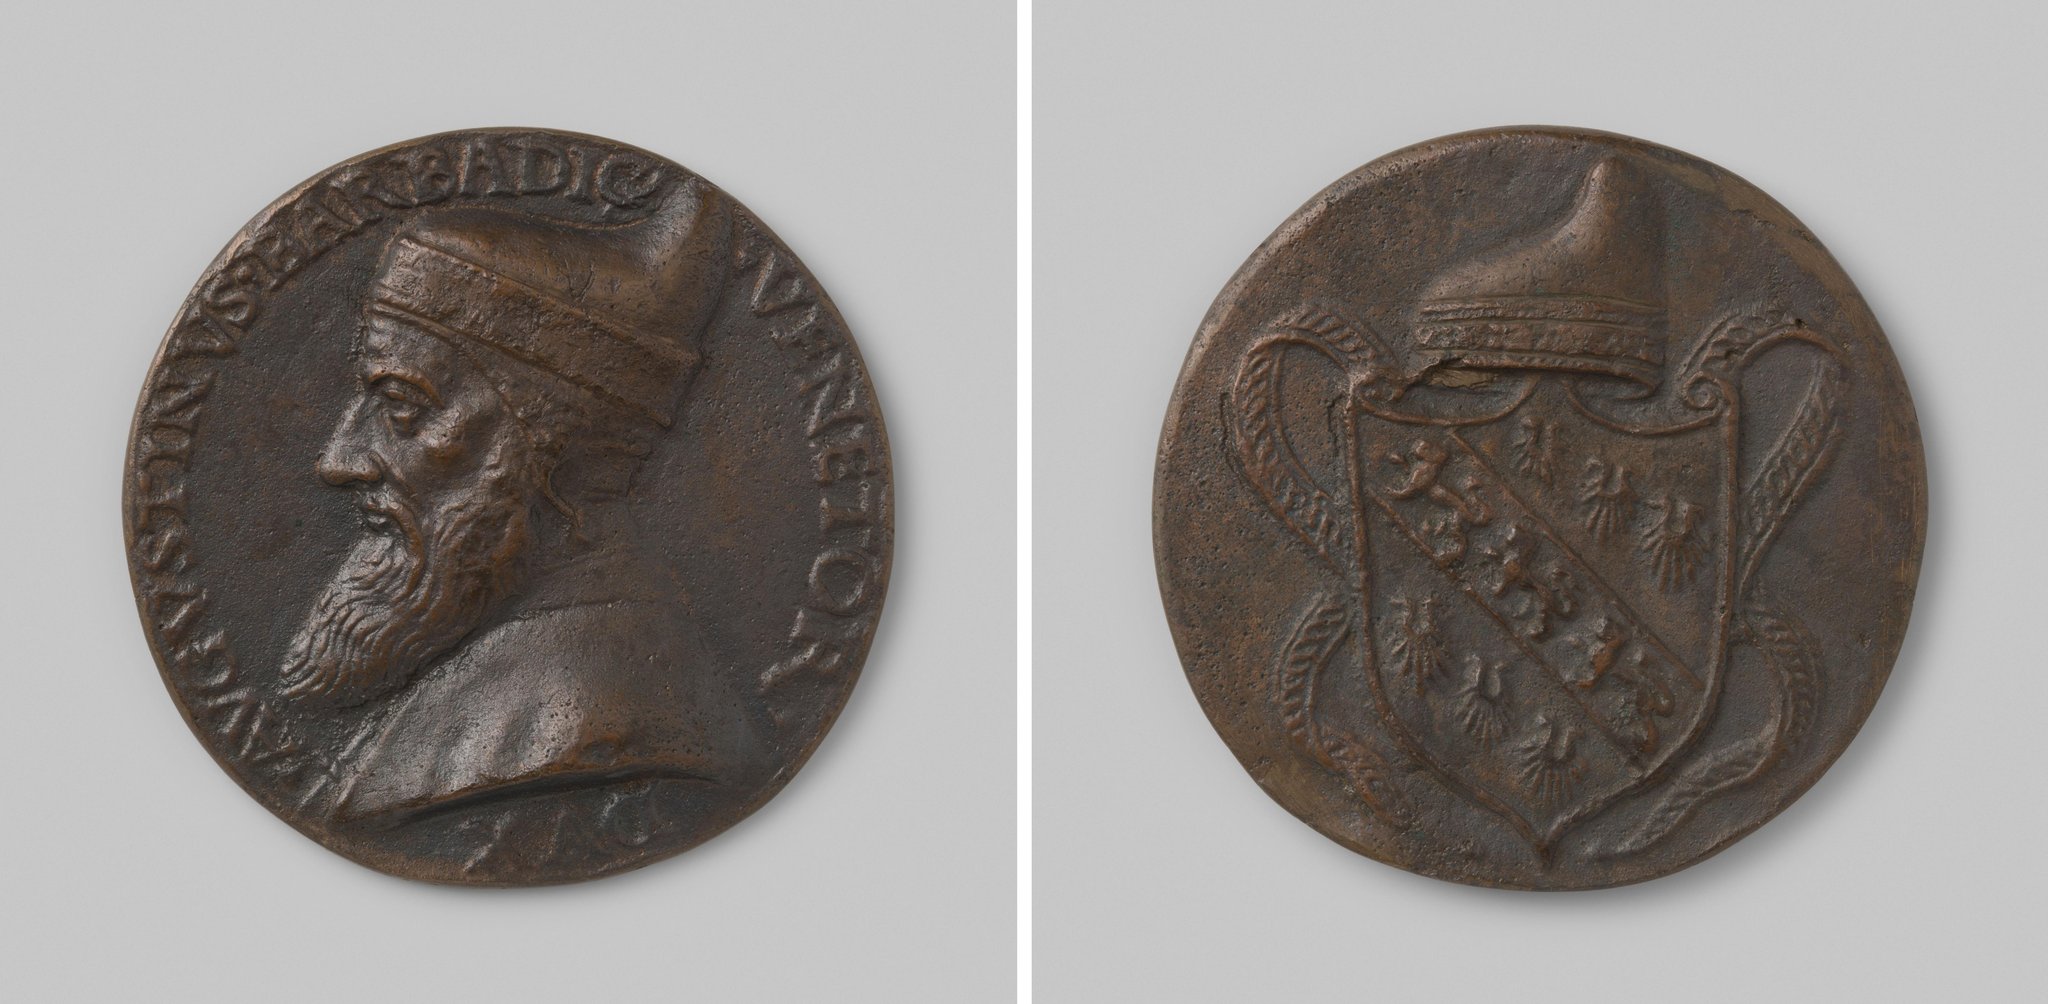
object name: history medal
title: Agostino Barbarigo, doge van Venetië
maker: Anonymous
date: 1486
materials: bronze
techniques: casting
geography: italy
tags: agostino barbarigo (doge van venetië)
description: Bronzen penning. Voorzijde: borststuk man met dogemuts binnen omschrift. Keerzijde: wapenschild gekroond met dogemuts